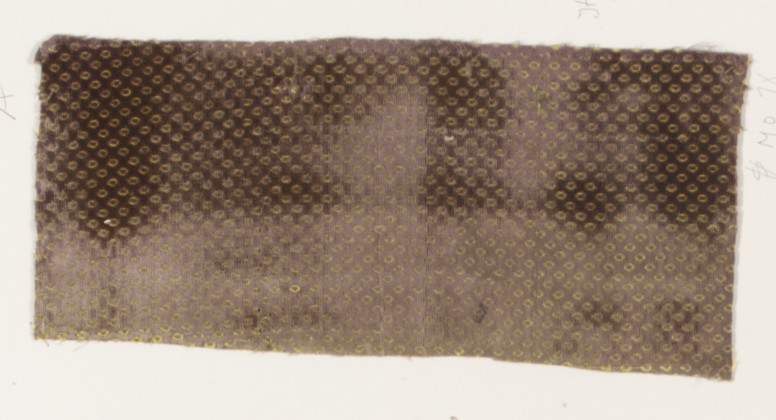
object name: fragment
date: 1701-1800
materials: silk